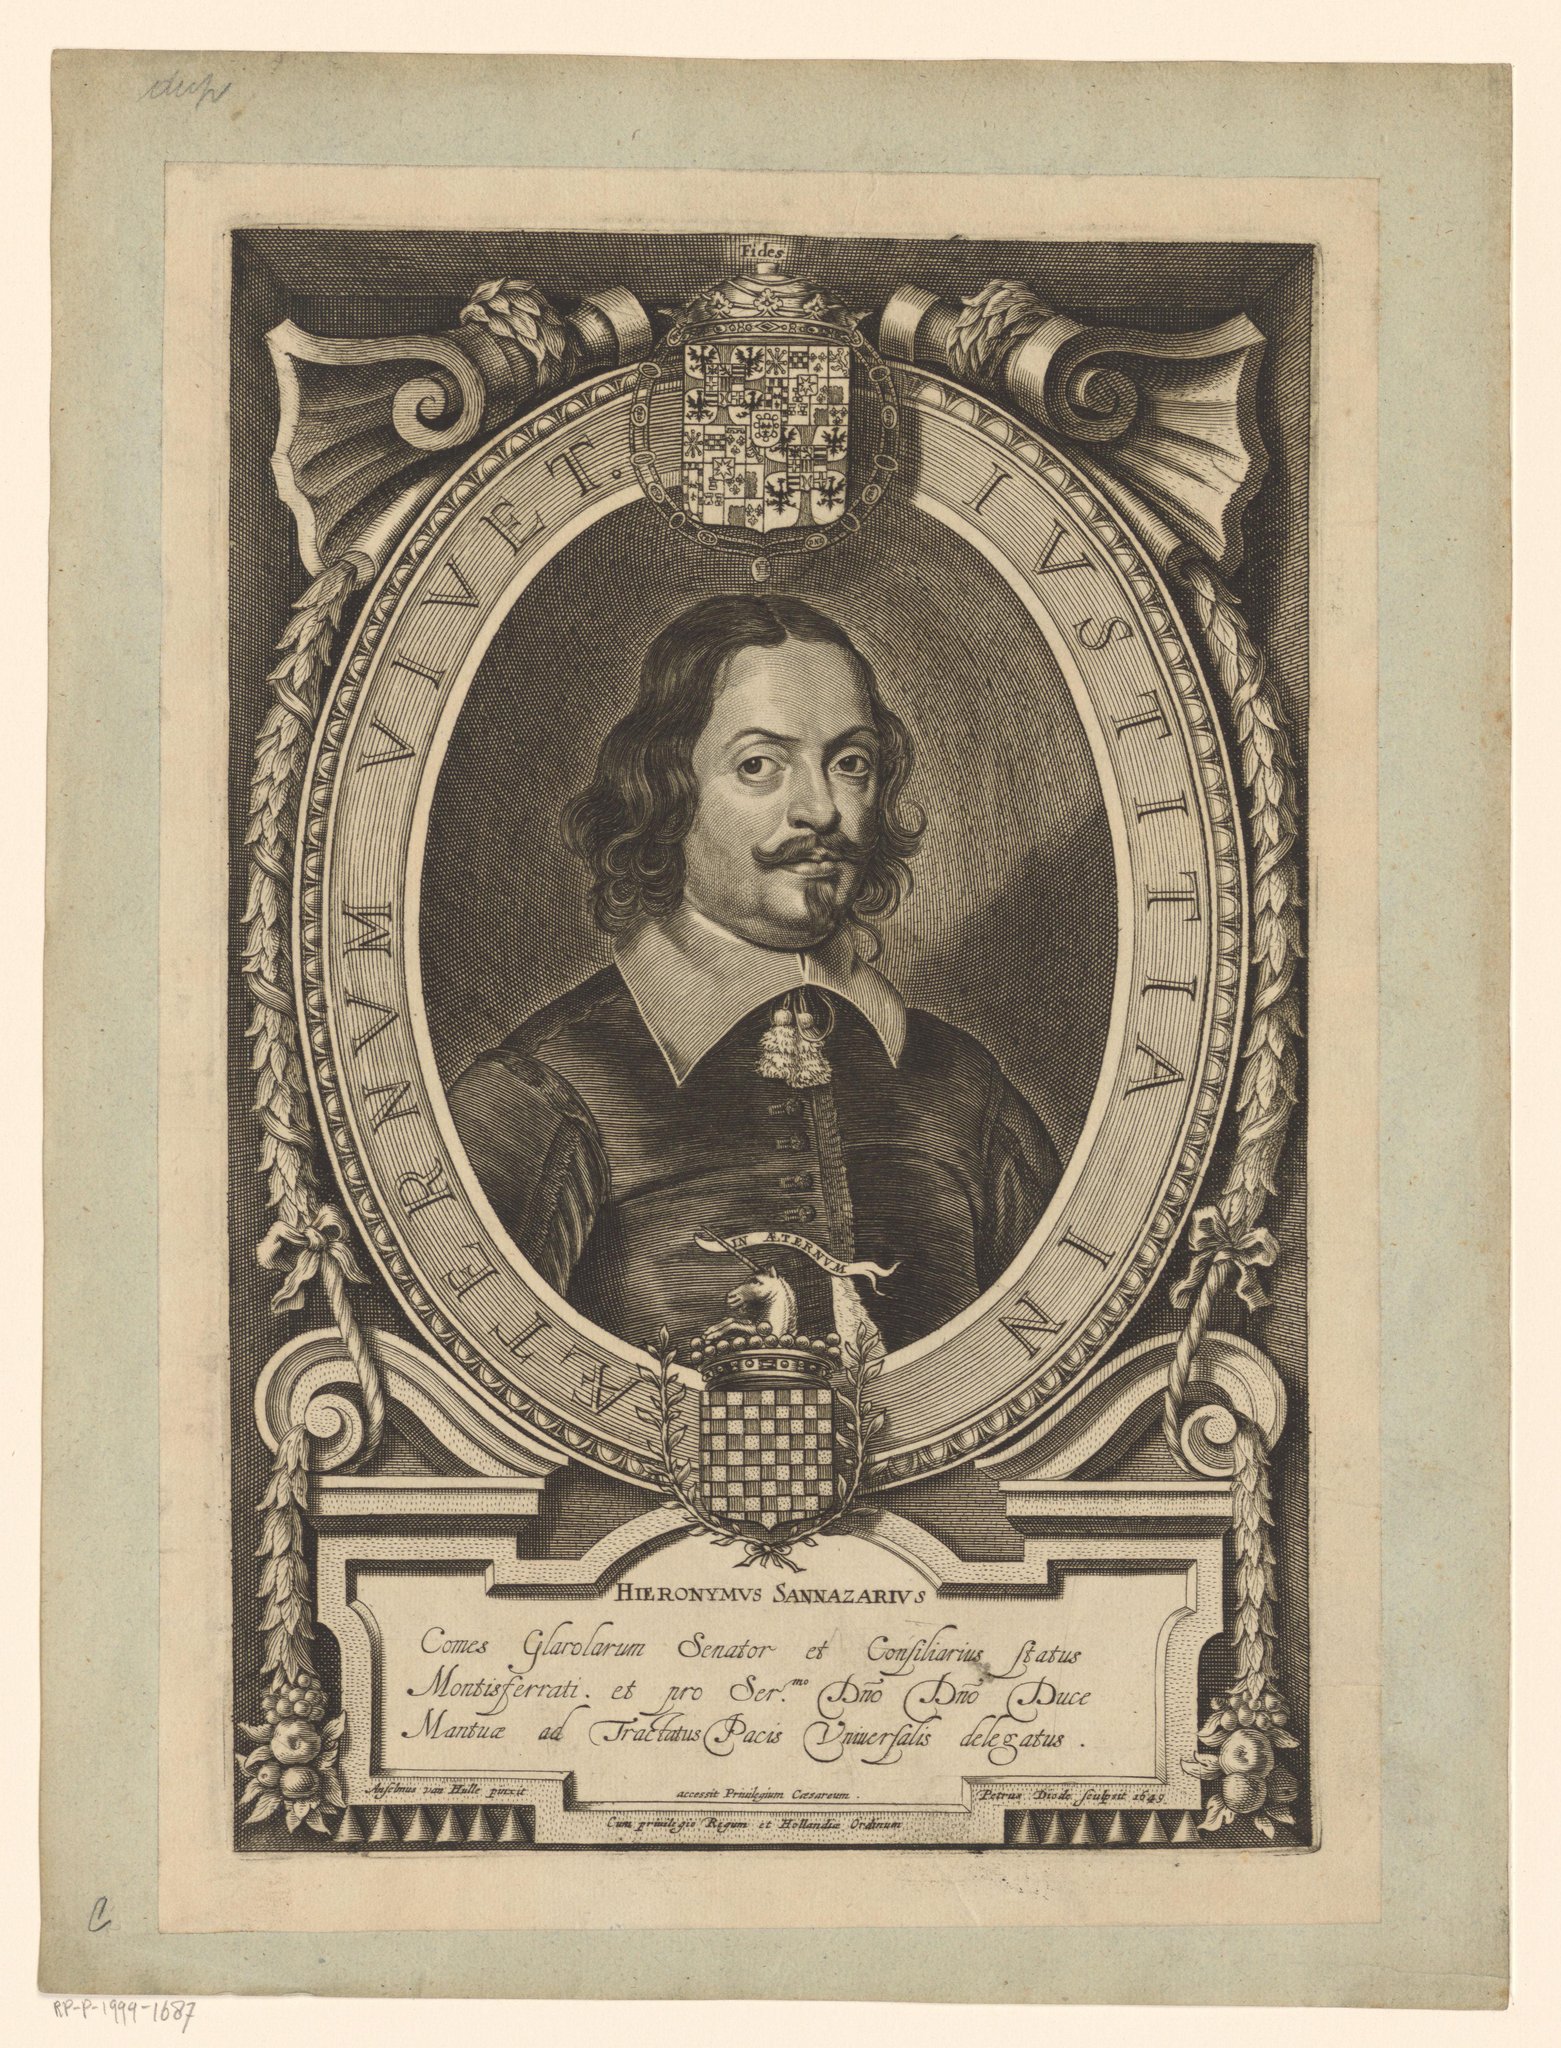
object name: print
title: Celeberrimi Legati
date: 1649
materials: paper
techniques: engraving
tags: historical persons, armorial bearing, heraldry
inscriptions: inscription: ‘Portr. 61284/ Sannazar/ S. 79985 A’, collector's mark: Lugt 2760, collector's mark: Lugt 2228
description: Portret van Girolamo Sannazaro. Het portret is gevat in een ovale omlijsting met het wapenschild van de geportretteerde, decoraties en een randschrift in het Latijn. In de cartouche een vierregelig onderschrift in het Latijn. Prent uit een serie portretten naar schilderijen van Anselmus van Hulle van alle gedelegeerden bij de vredesonderhandelingen te Münster en Osnabrück.